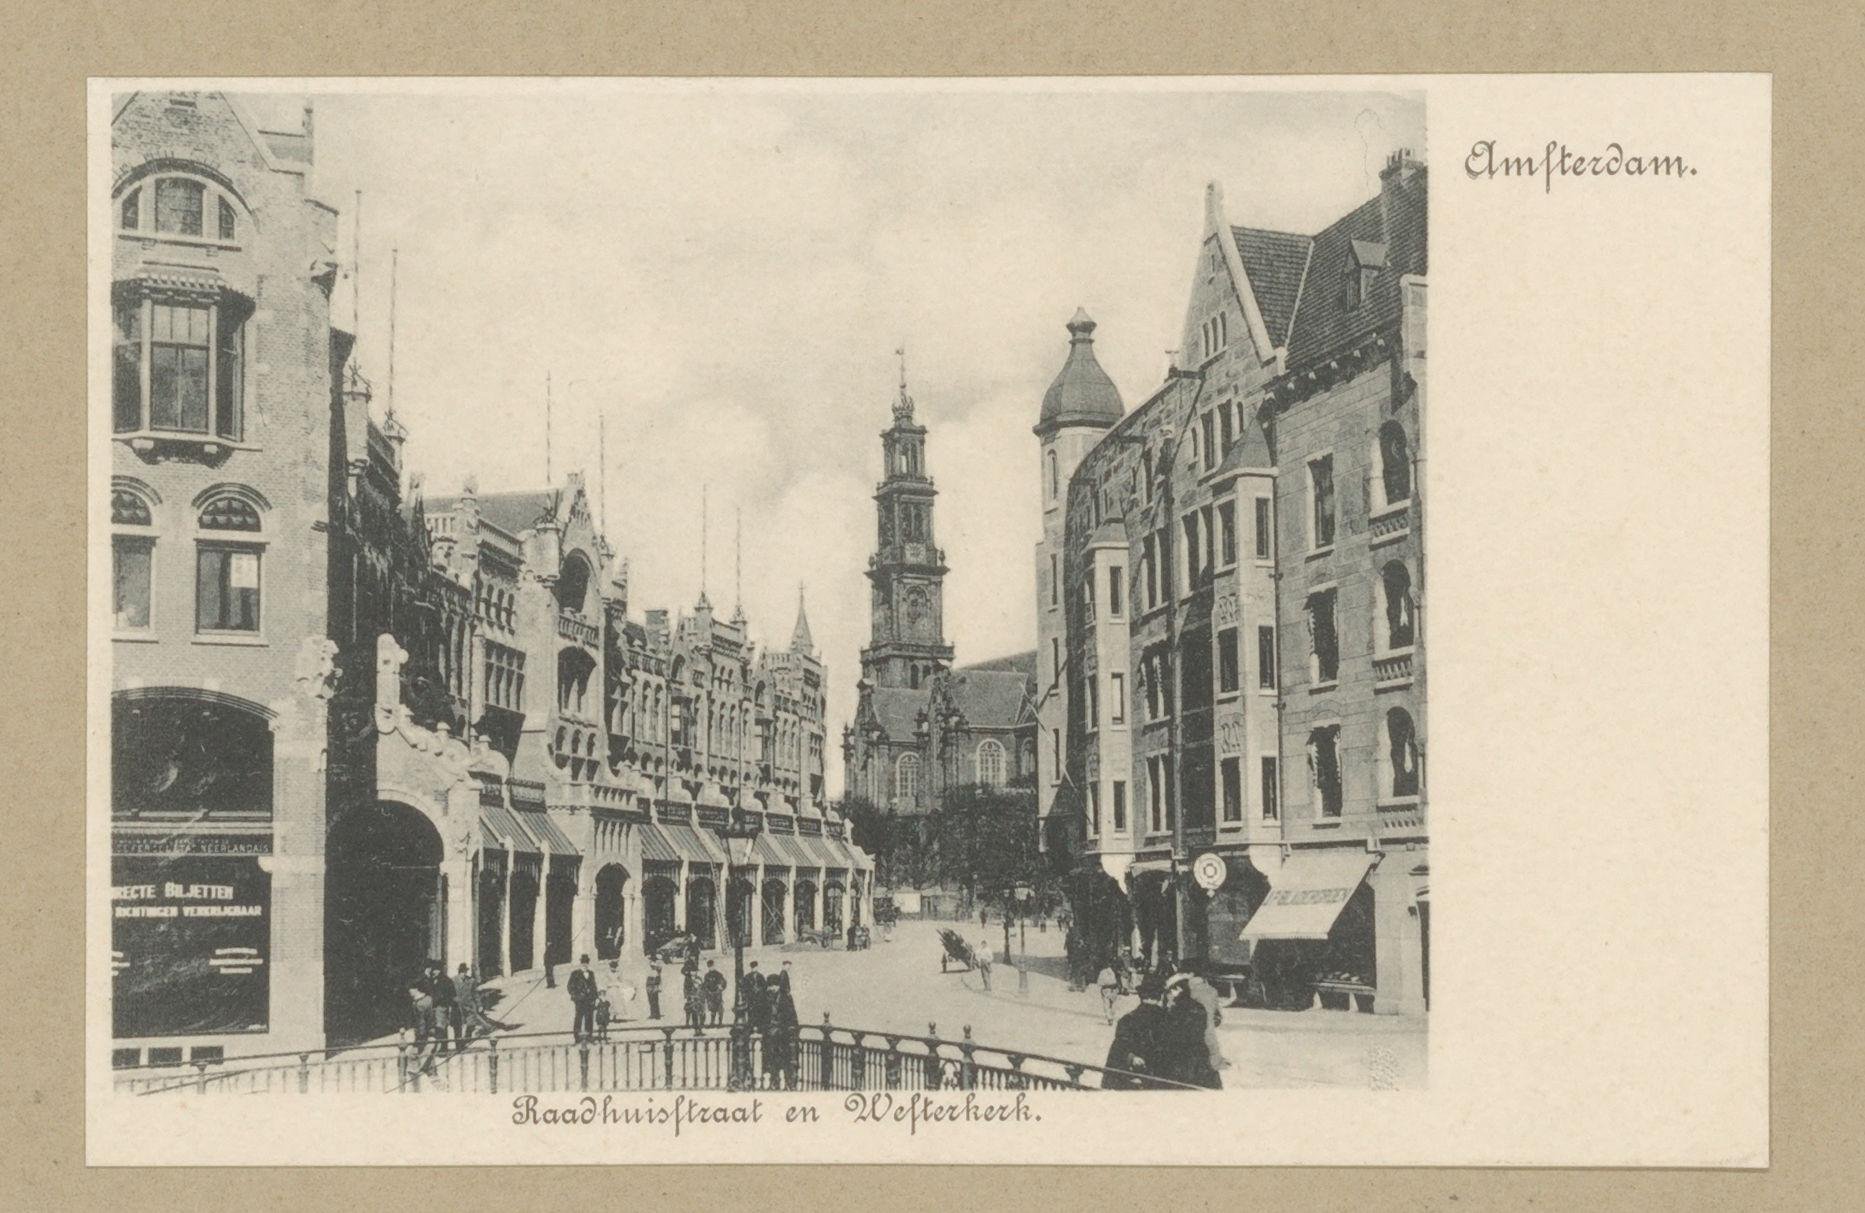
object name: ansichtkaart, prentbriefkaart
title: Gezicht op de Raadhuisstraat met de Westerkerkstoren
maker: Anonymous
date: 1875-1905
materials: cardboard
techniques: photograph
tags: tower, clock tower ~ monumental adornment, city-view in general; 'veduta', street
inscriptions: collector's mark: ‘11.102AB’ Lugt 1641b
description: Onderwerpsrubriek binnen de Atlas Amsterdam: Raadhuisstraat, Raamgracht, Raamplein, Rapenburgerstraat, Reguliersgracht, Reguliersbreestraat.